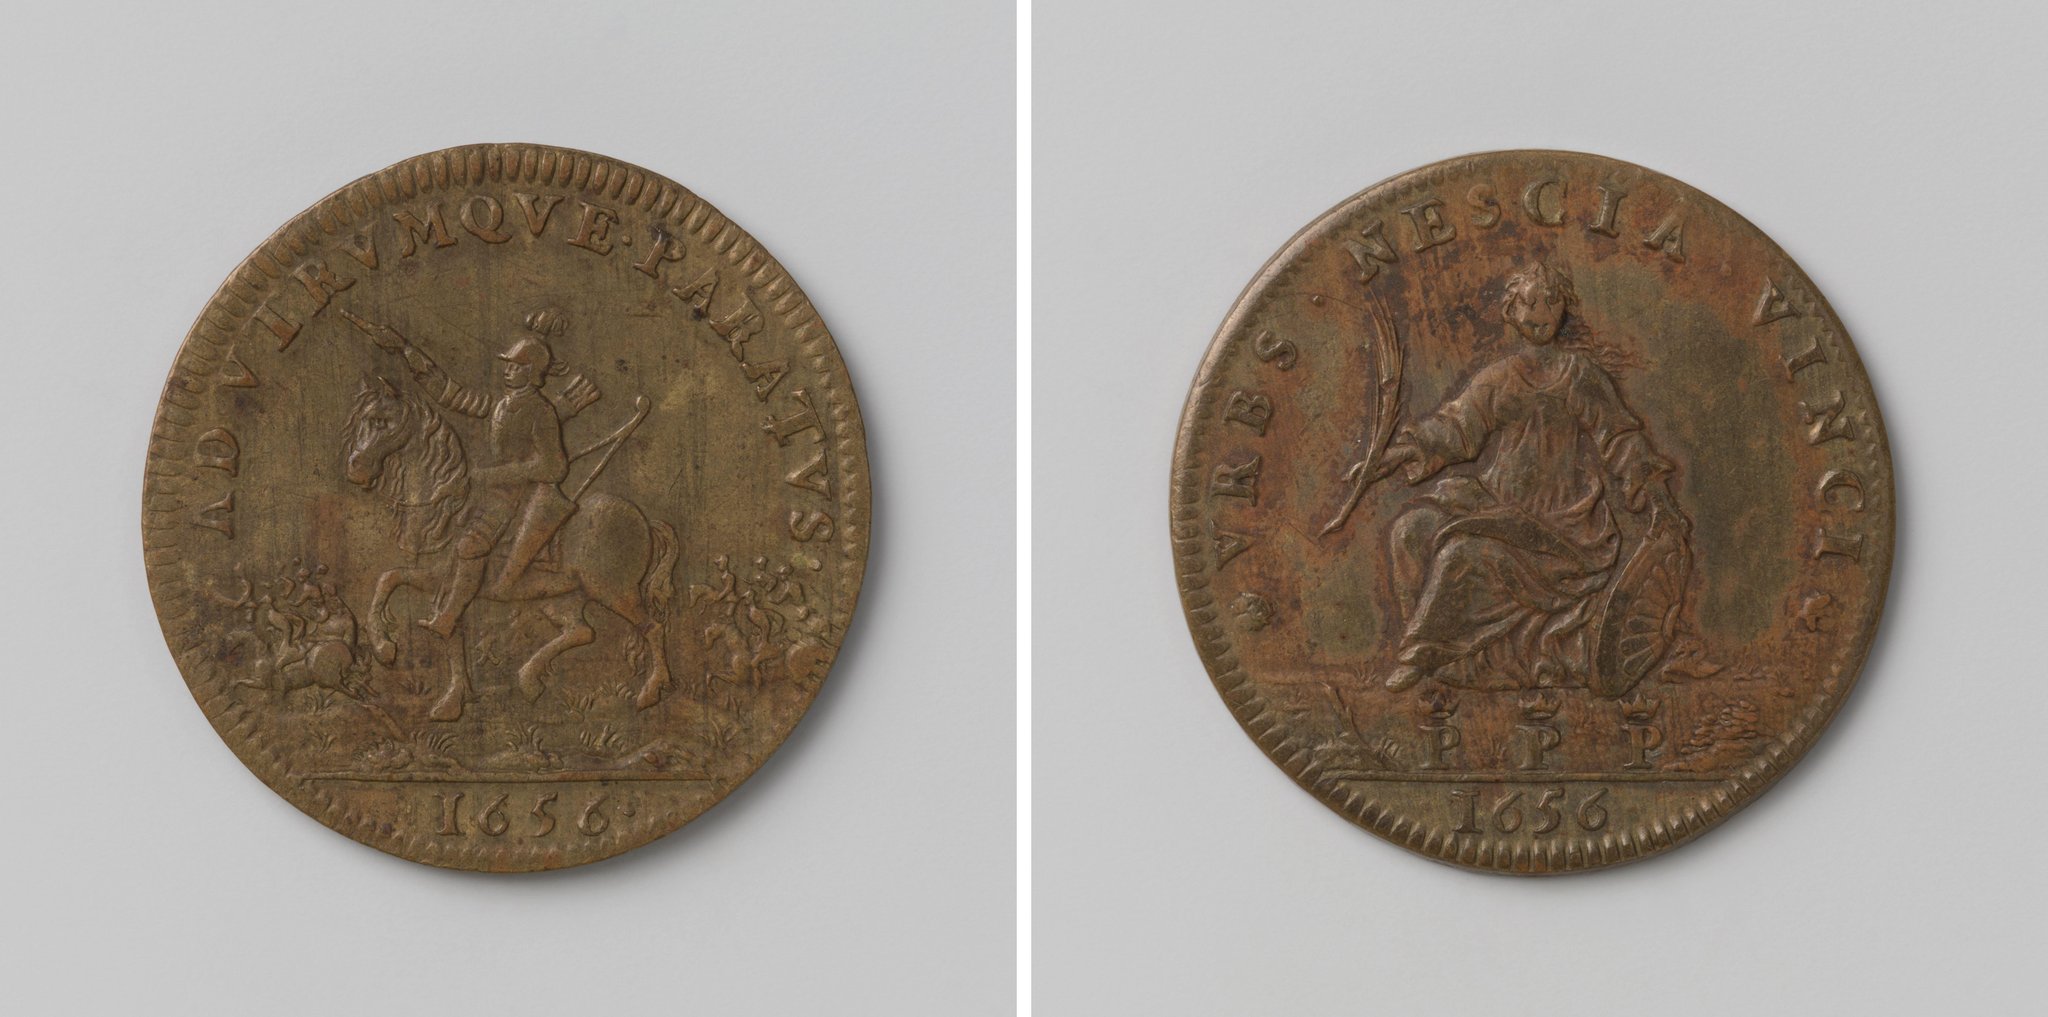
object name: jeton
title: Verlangen naar vrede in Frankrijk, rekenpenning ter ere van Lodewijk XIV, koning van Frankrijk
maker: Anonymous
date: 1656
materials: copper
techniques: striking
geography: france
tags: lodewijk xiv (koning van frankrijk)